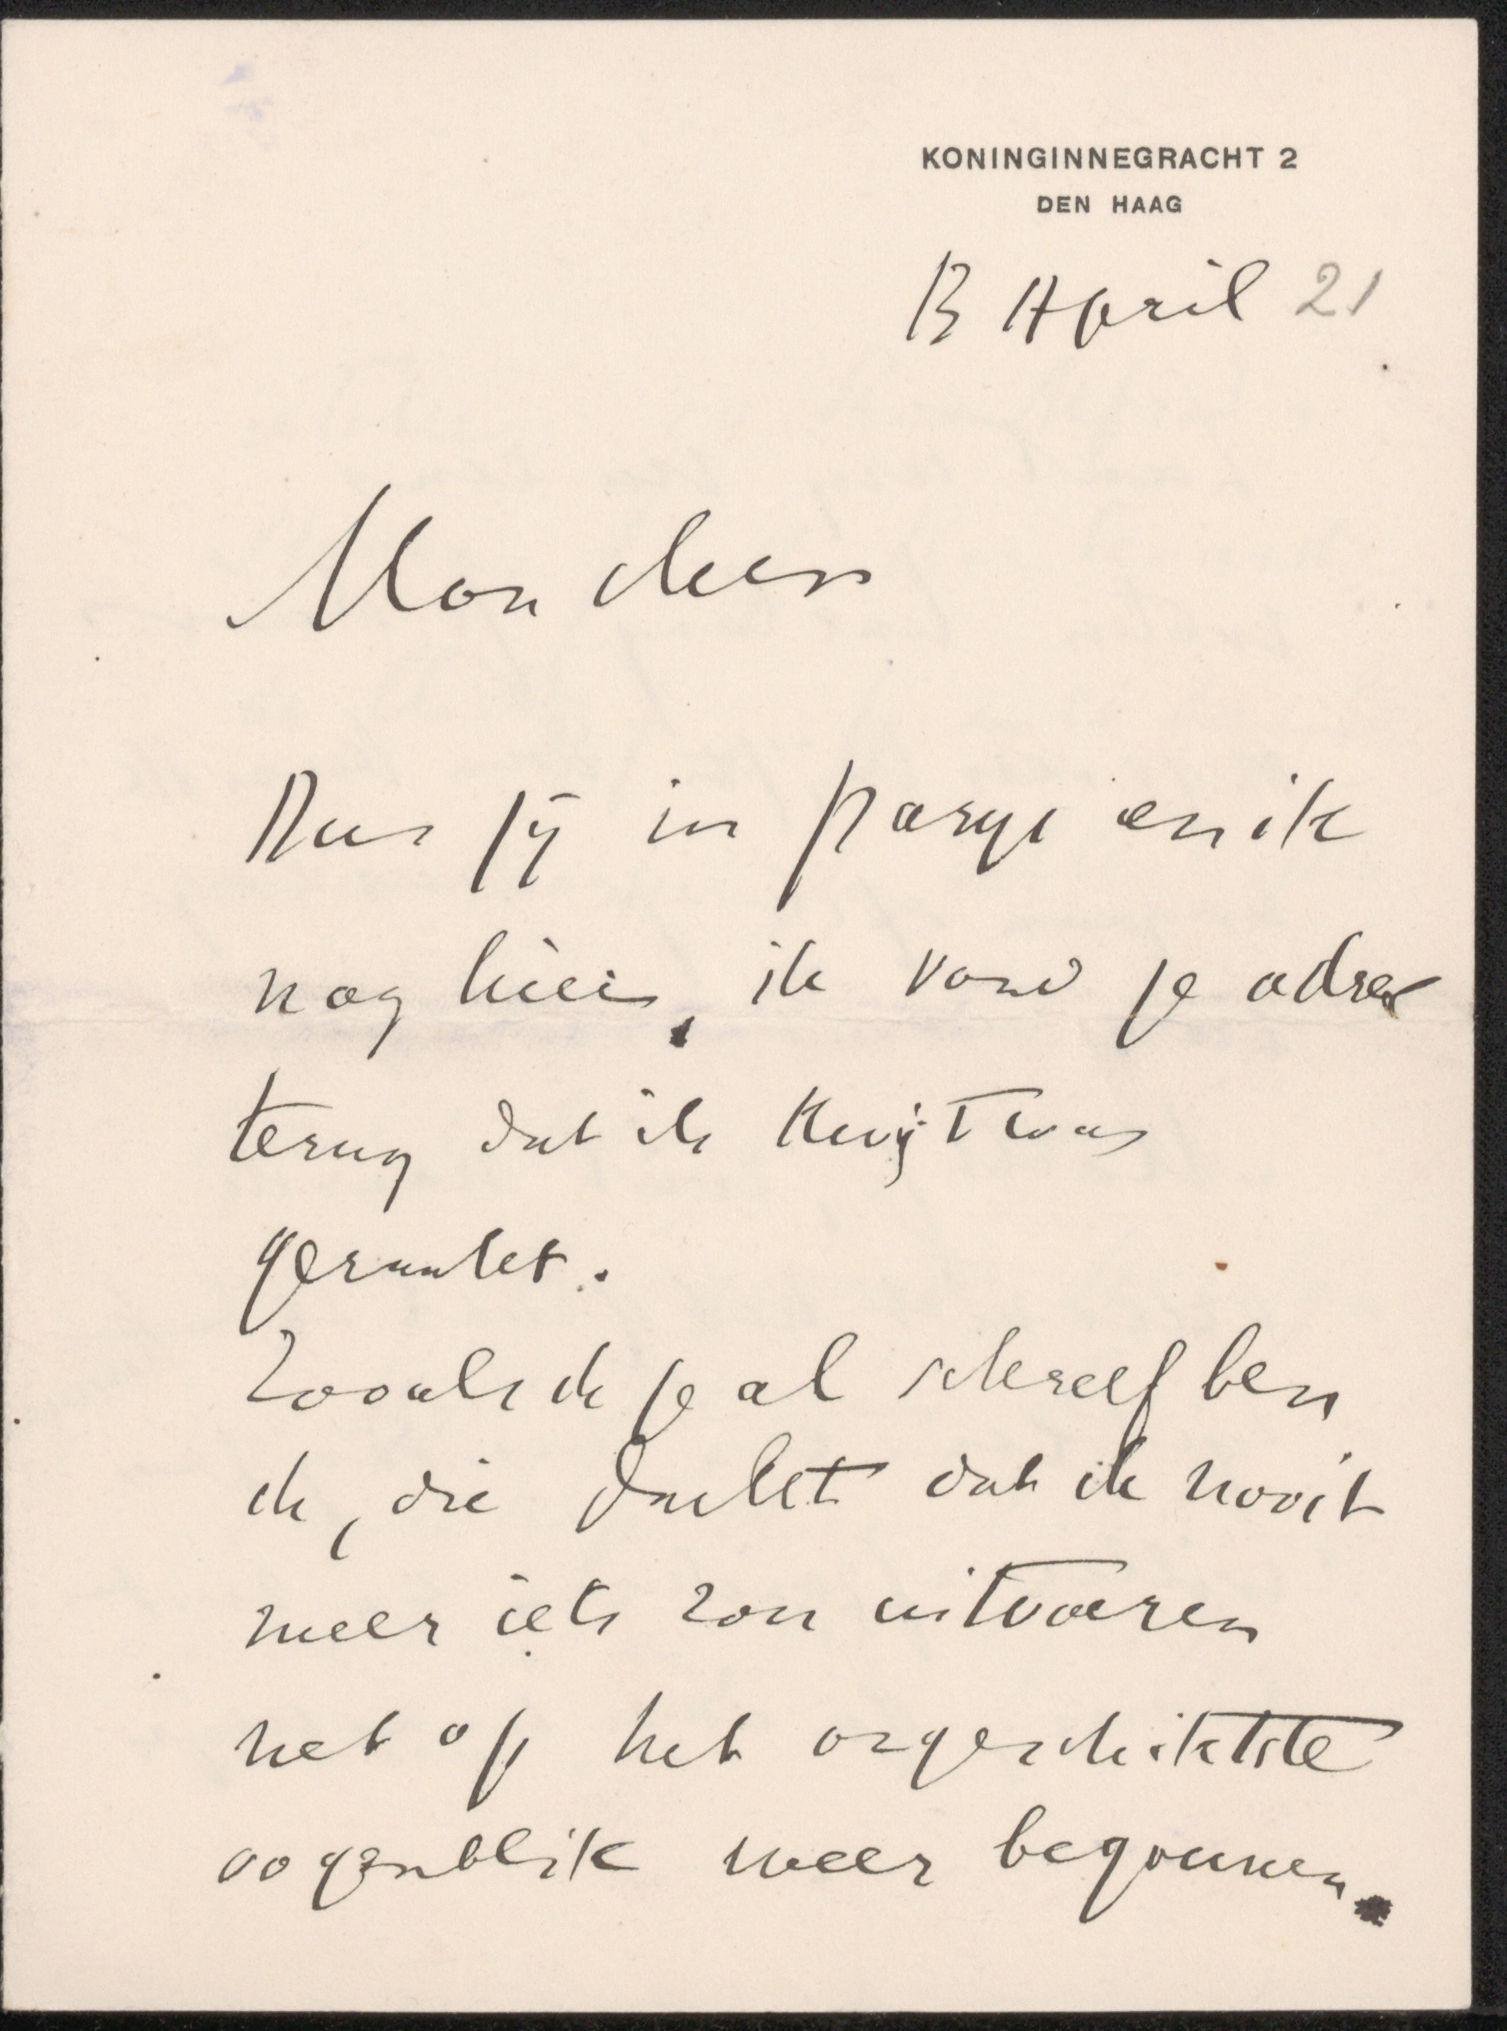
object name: letter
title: Brief aan Jan Veth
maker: isaac israels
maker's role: draughtsman, painter, print maker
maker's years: 1865-1934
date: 1875-1925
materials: ink, paper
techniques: pen, printing, writing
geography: the hague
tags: dordrecht, amsterdam, painter, draughtsman, designer, jan veth, workshop, studio of the artist (in general), paris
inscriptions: collector's mark: ‘RPK’